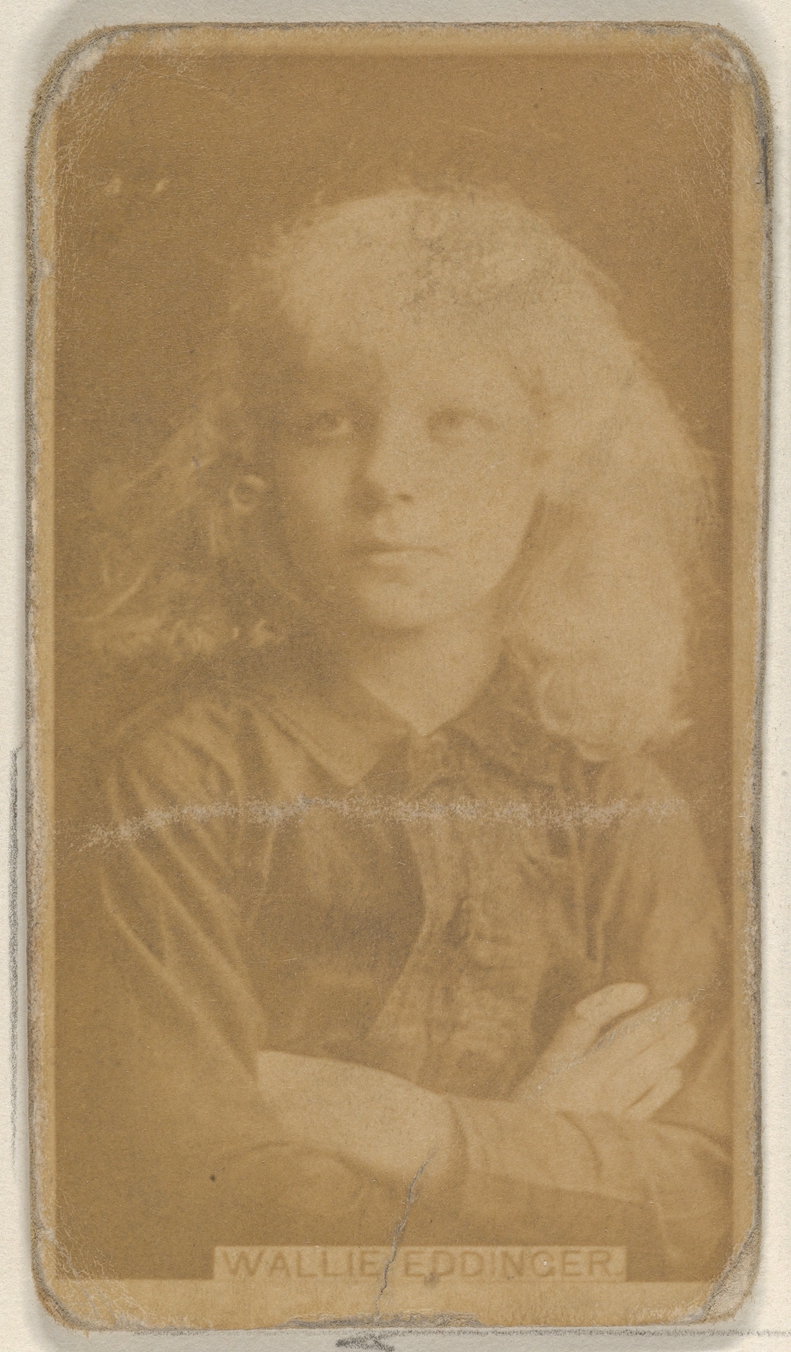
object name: photograph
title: Wallie Eddinger, from the Actors and Actresses series (N45, Type 8) for Virginia Brights Cigarettes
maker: allen & ginter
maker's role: publisher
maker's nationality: american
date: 1888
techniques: albumen silver print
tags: girls,portraits,actresses